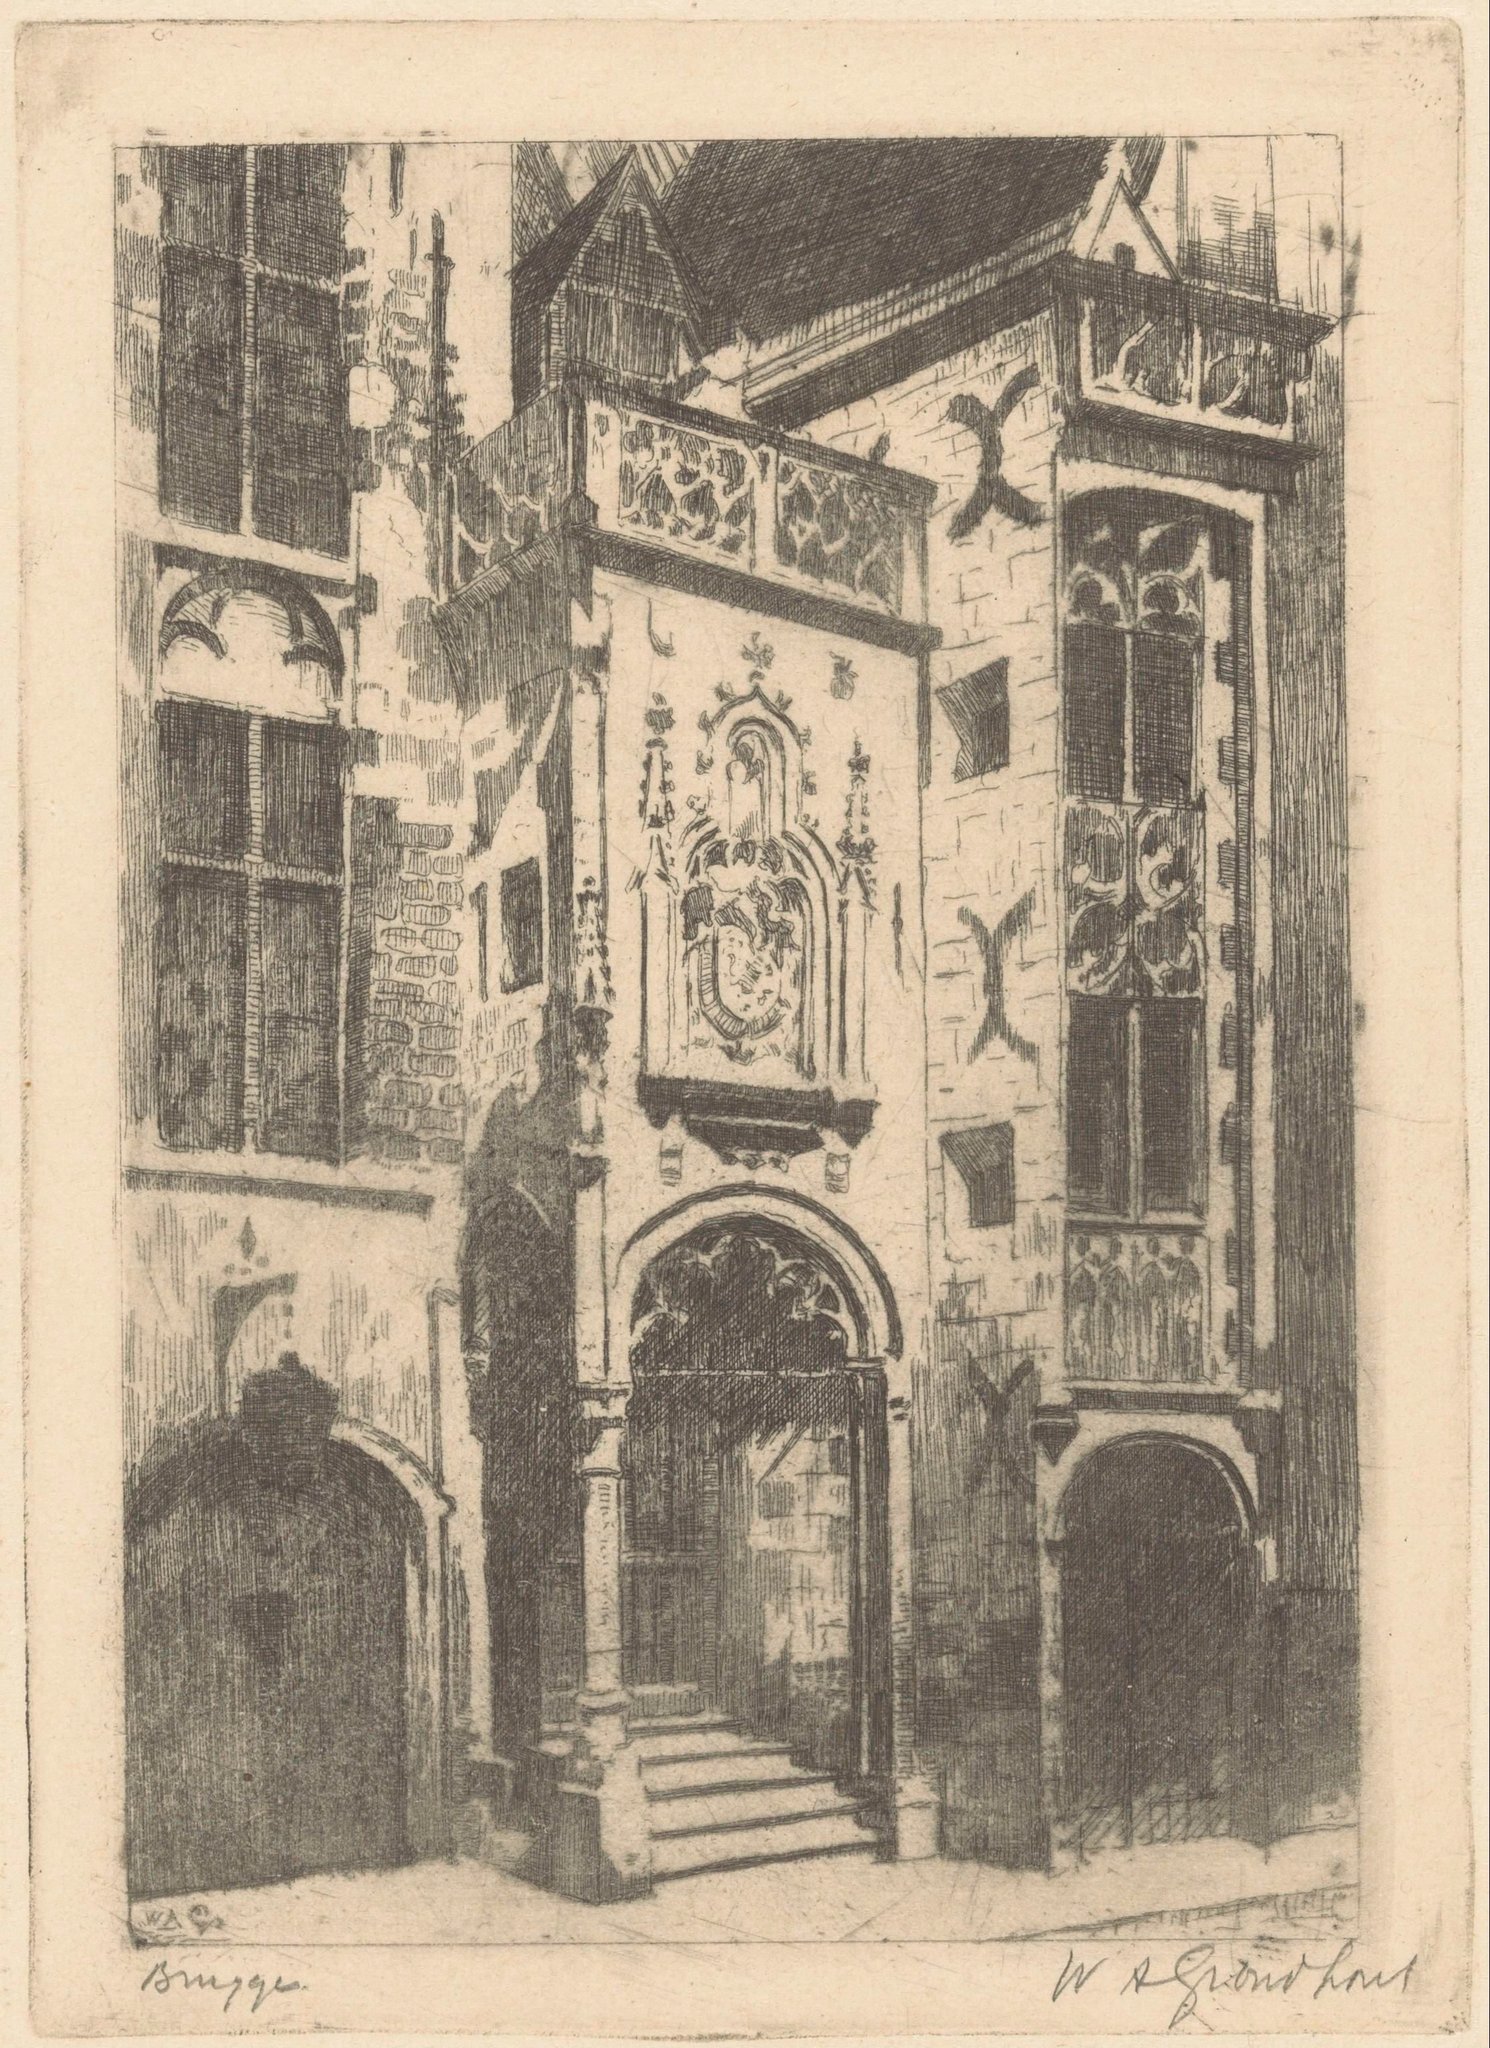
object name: print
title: Brugge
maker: willem adrianus grondhout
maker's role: draughtsman, painter, print maker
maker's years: 1878-1934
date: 1888-1934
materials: paper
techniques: etching, intaglio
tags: windmill, bruges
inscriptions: collector's mark: Lugt 2228